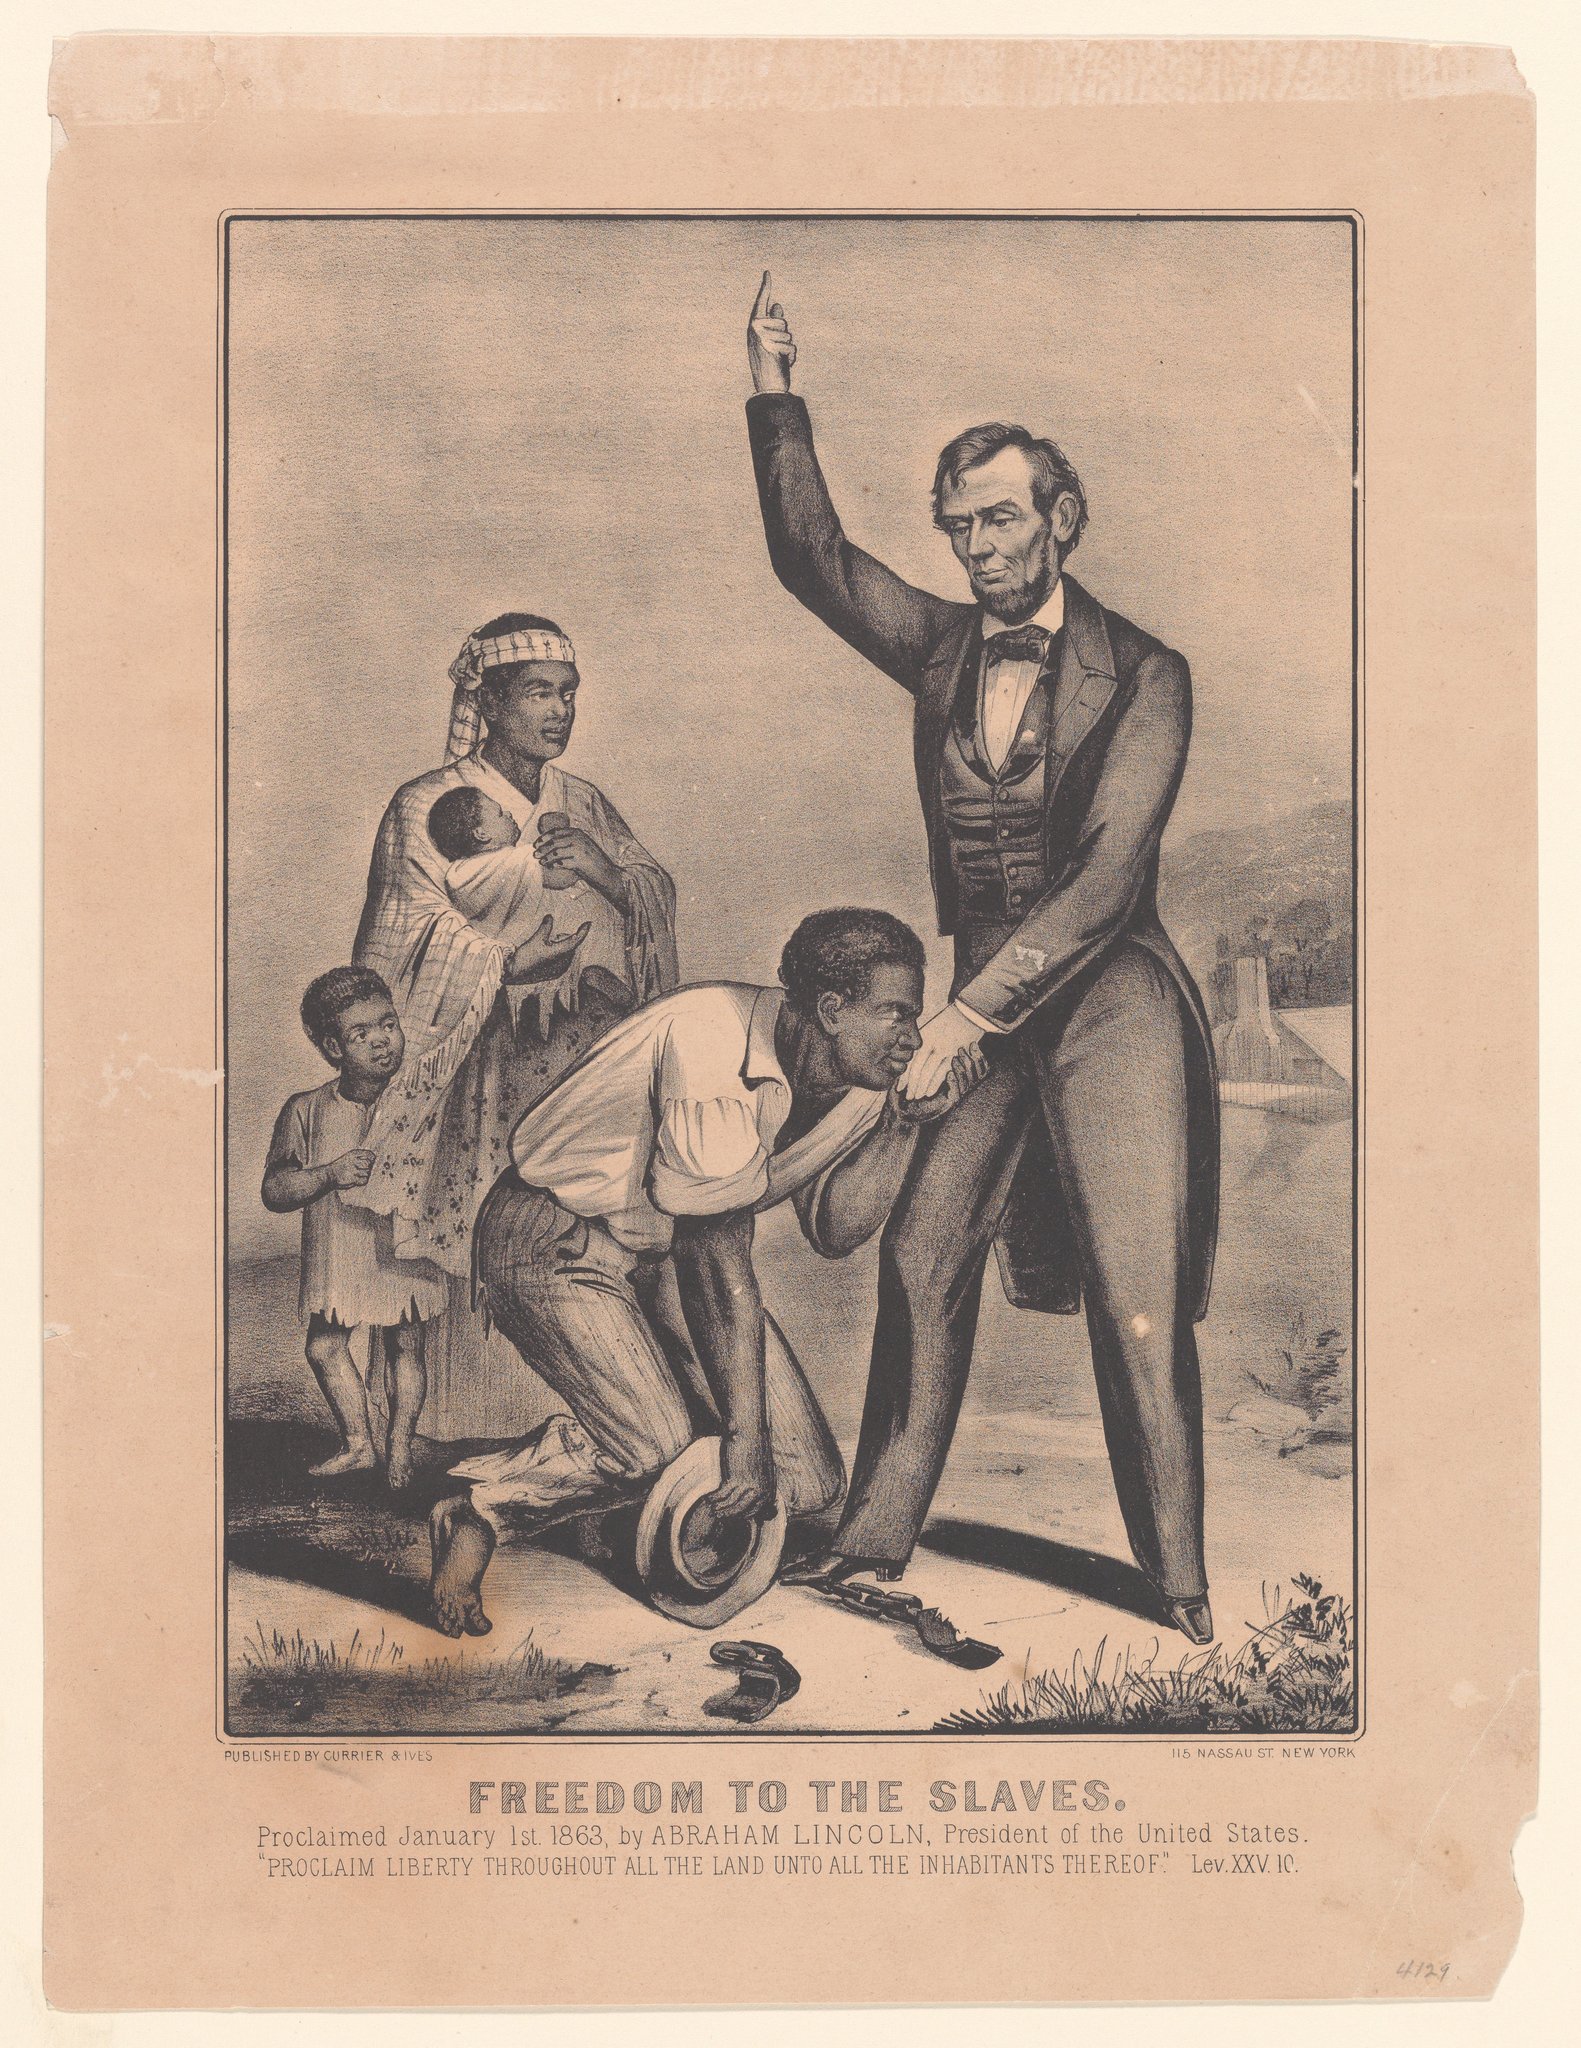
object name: print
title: Freedom to the Slaves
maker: currier & ives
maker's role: publisher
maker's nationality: american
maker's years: 1857-1907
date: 1865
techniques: lithograph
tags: abraham lincoln